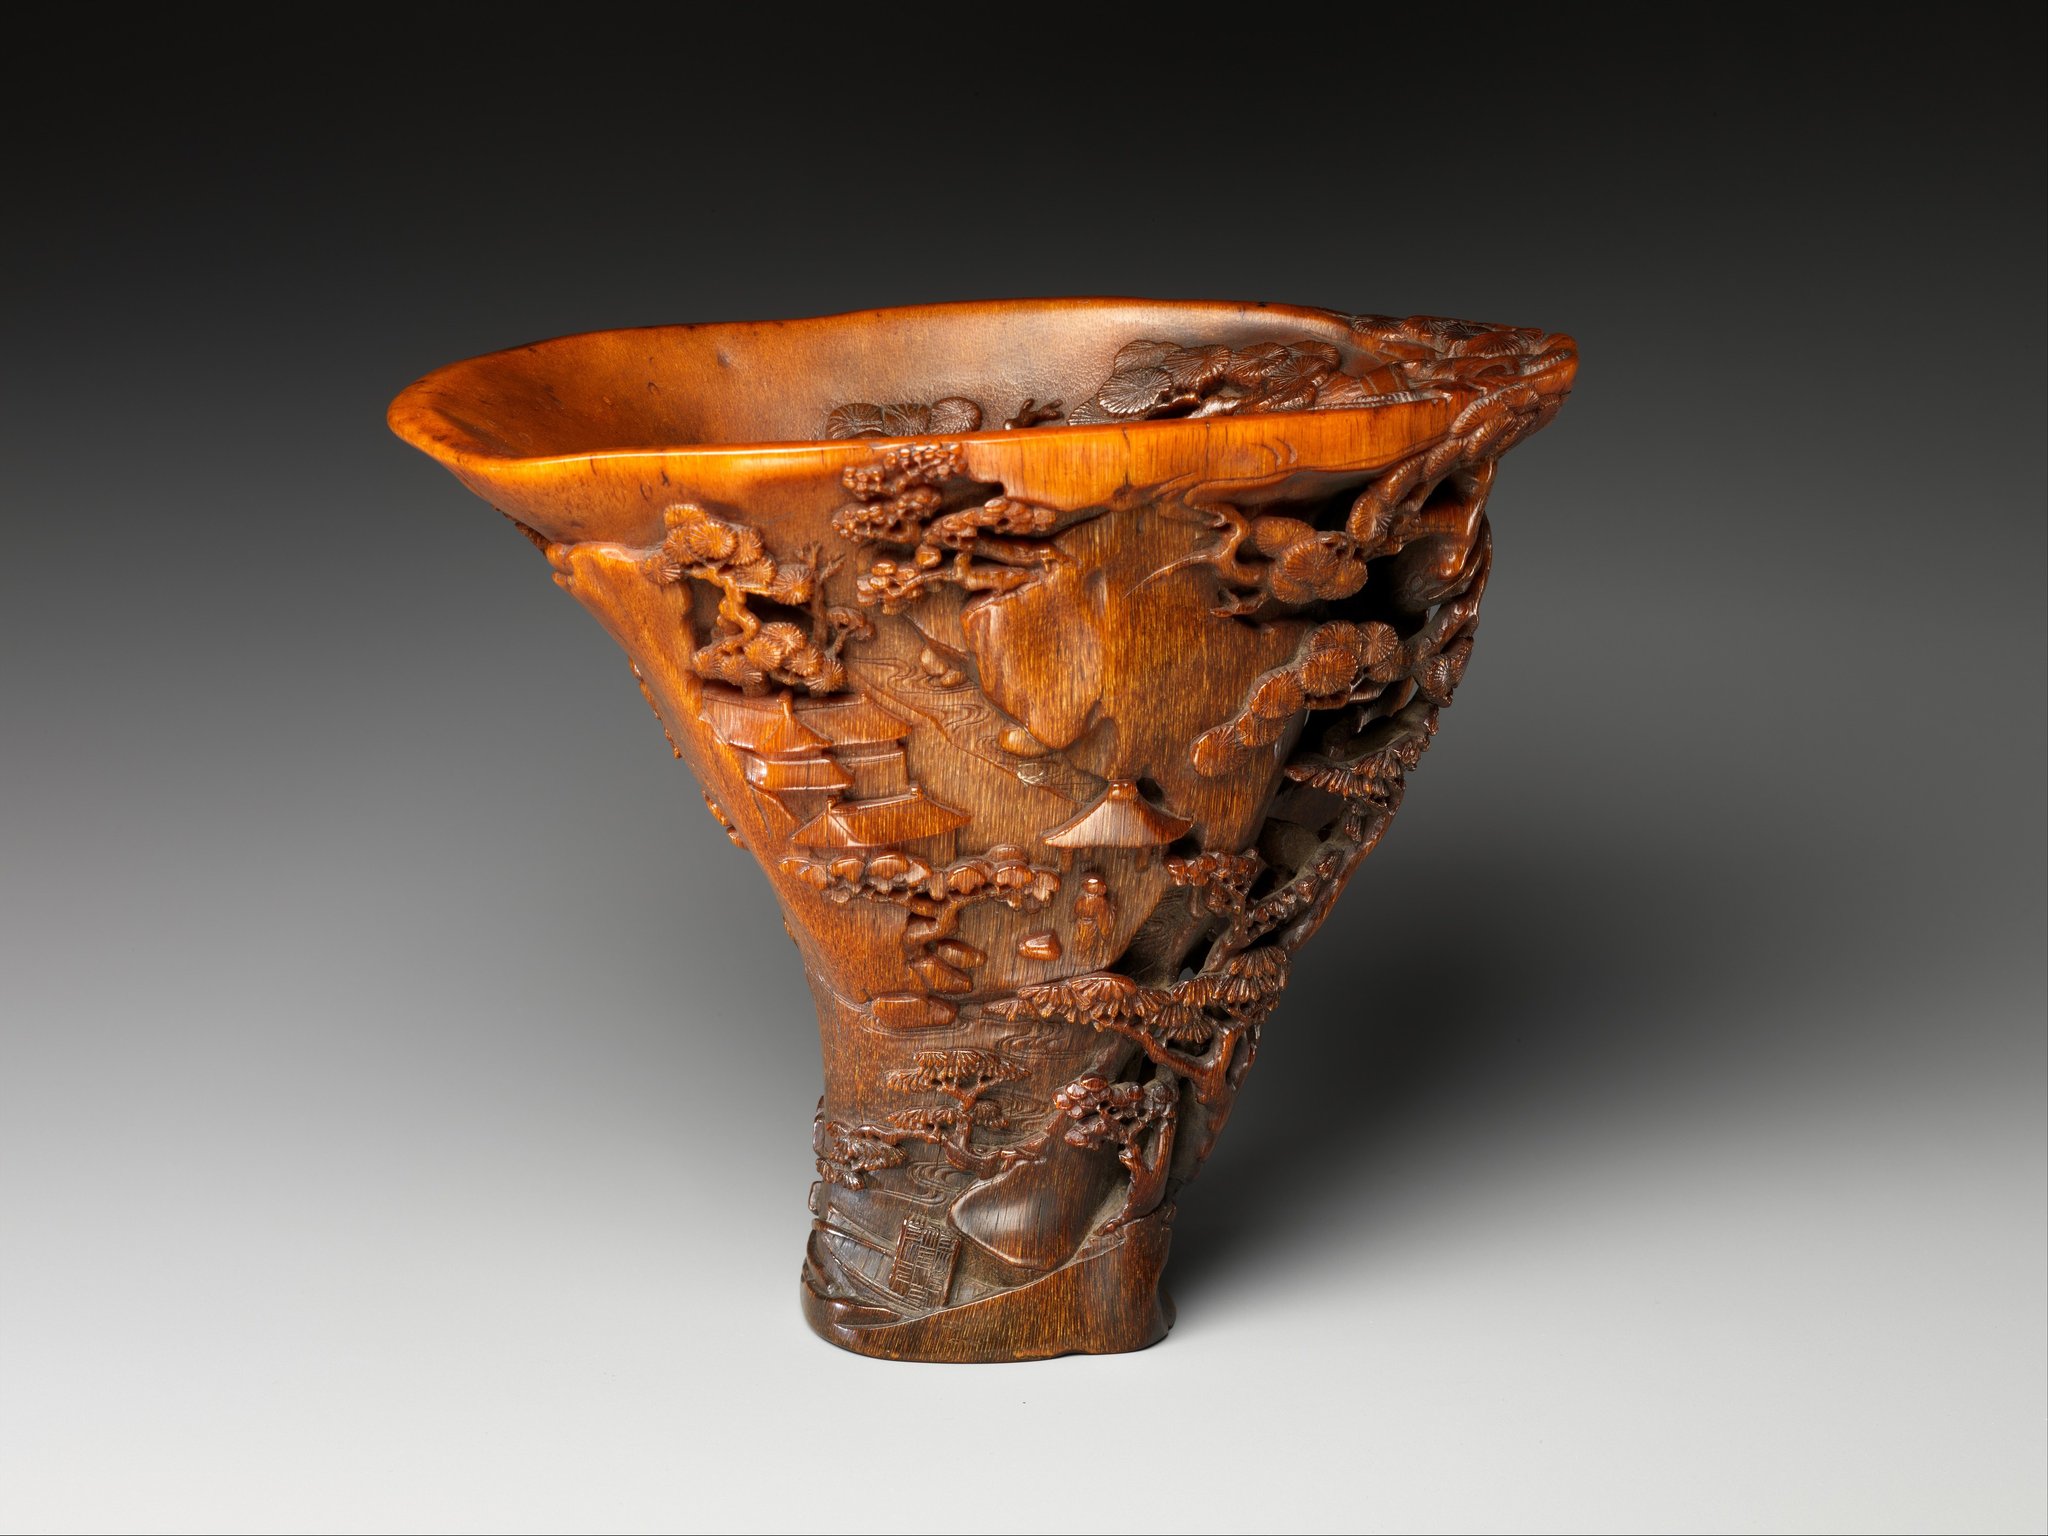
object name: cup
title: Cup with figures in a landscape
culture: chinese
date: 1701-1800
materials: horn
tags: human figures,landscapes,trees